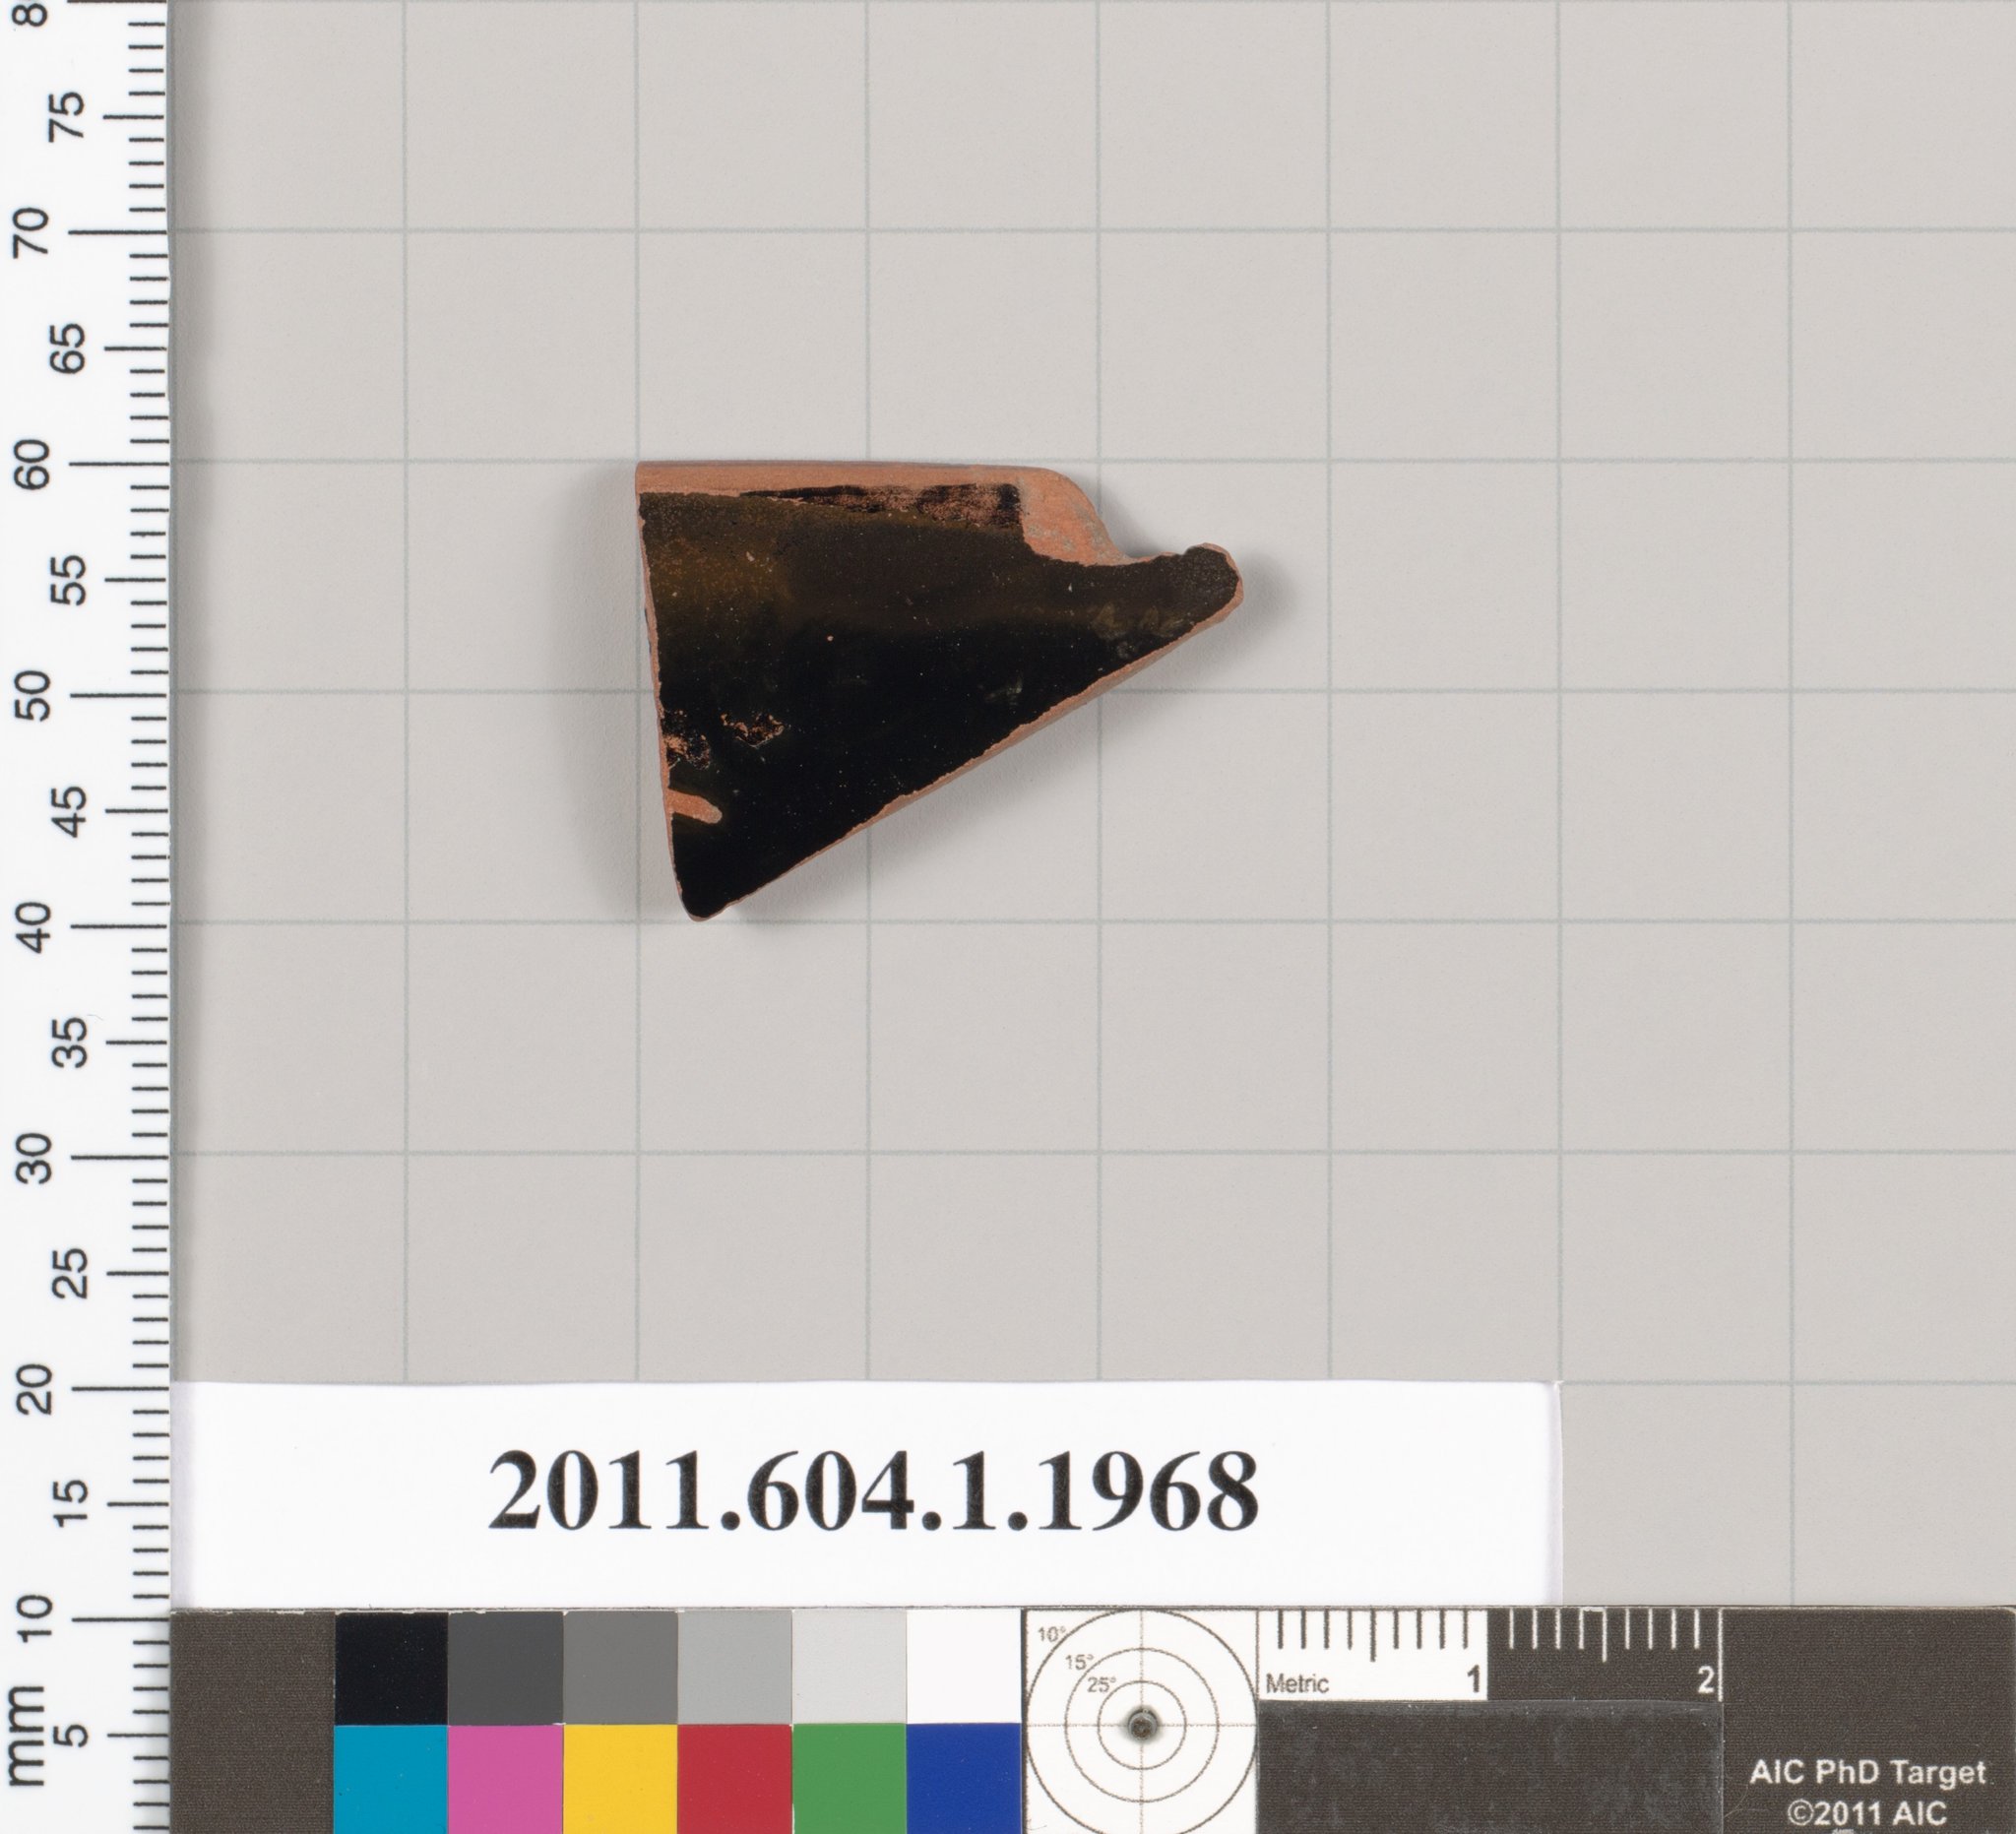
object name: kylix fragment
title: Terracotta rim fragment of a kylix (drinking cup)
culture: greek, attic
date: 475-451 BCE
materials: terracotta